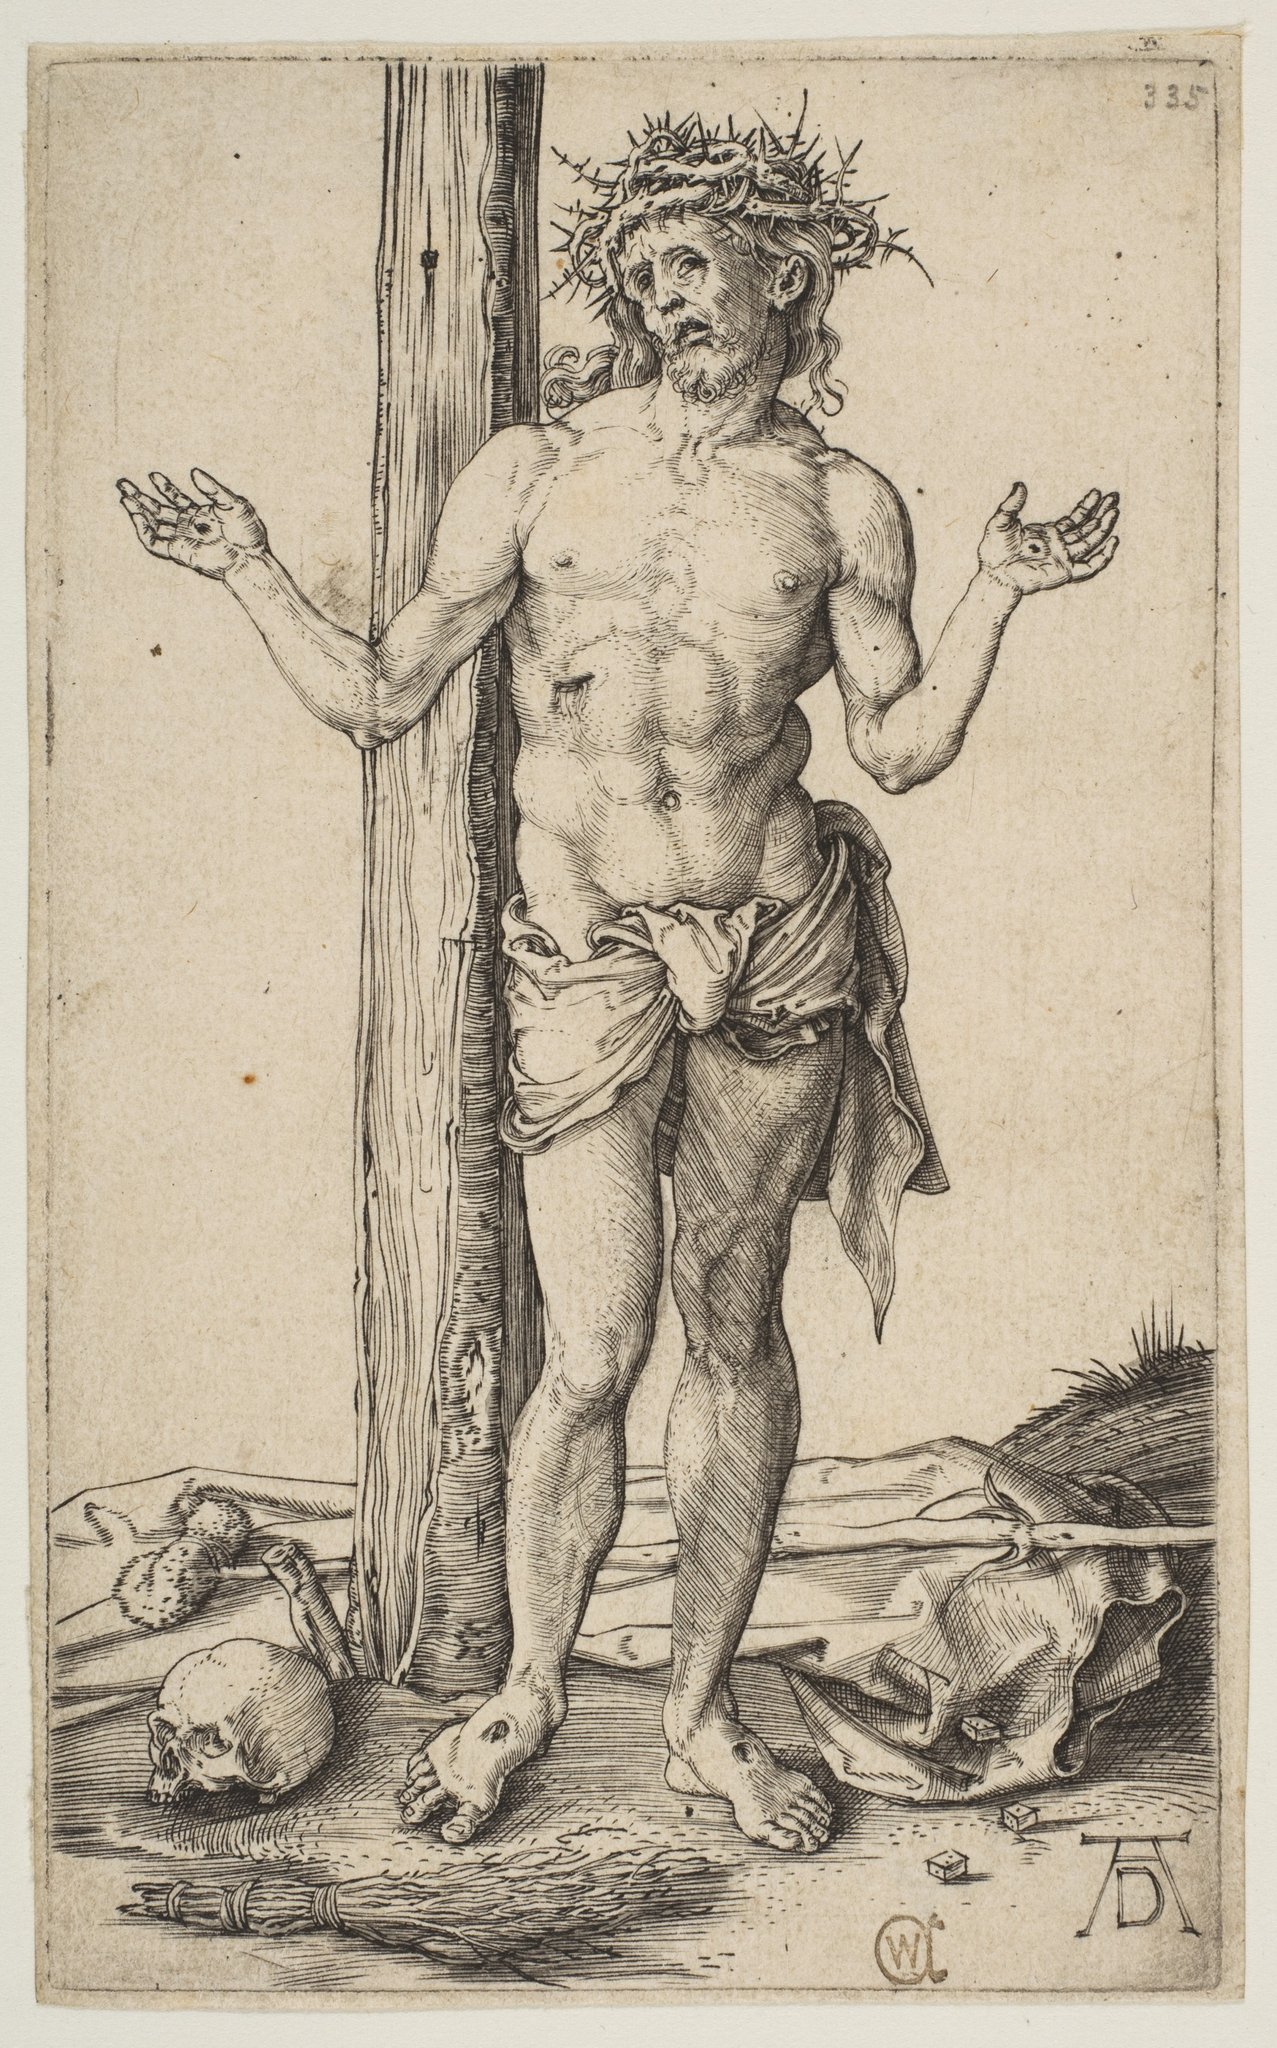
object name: print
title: Man of Sorrows with Arms Outstretched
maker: albrecht dürer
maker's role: artist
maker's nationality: german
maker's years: 1471-1528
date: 1500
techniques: engraving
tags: christ